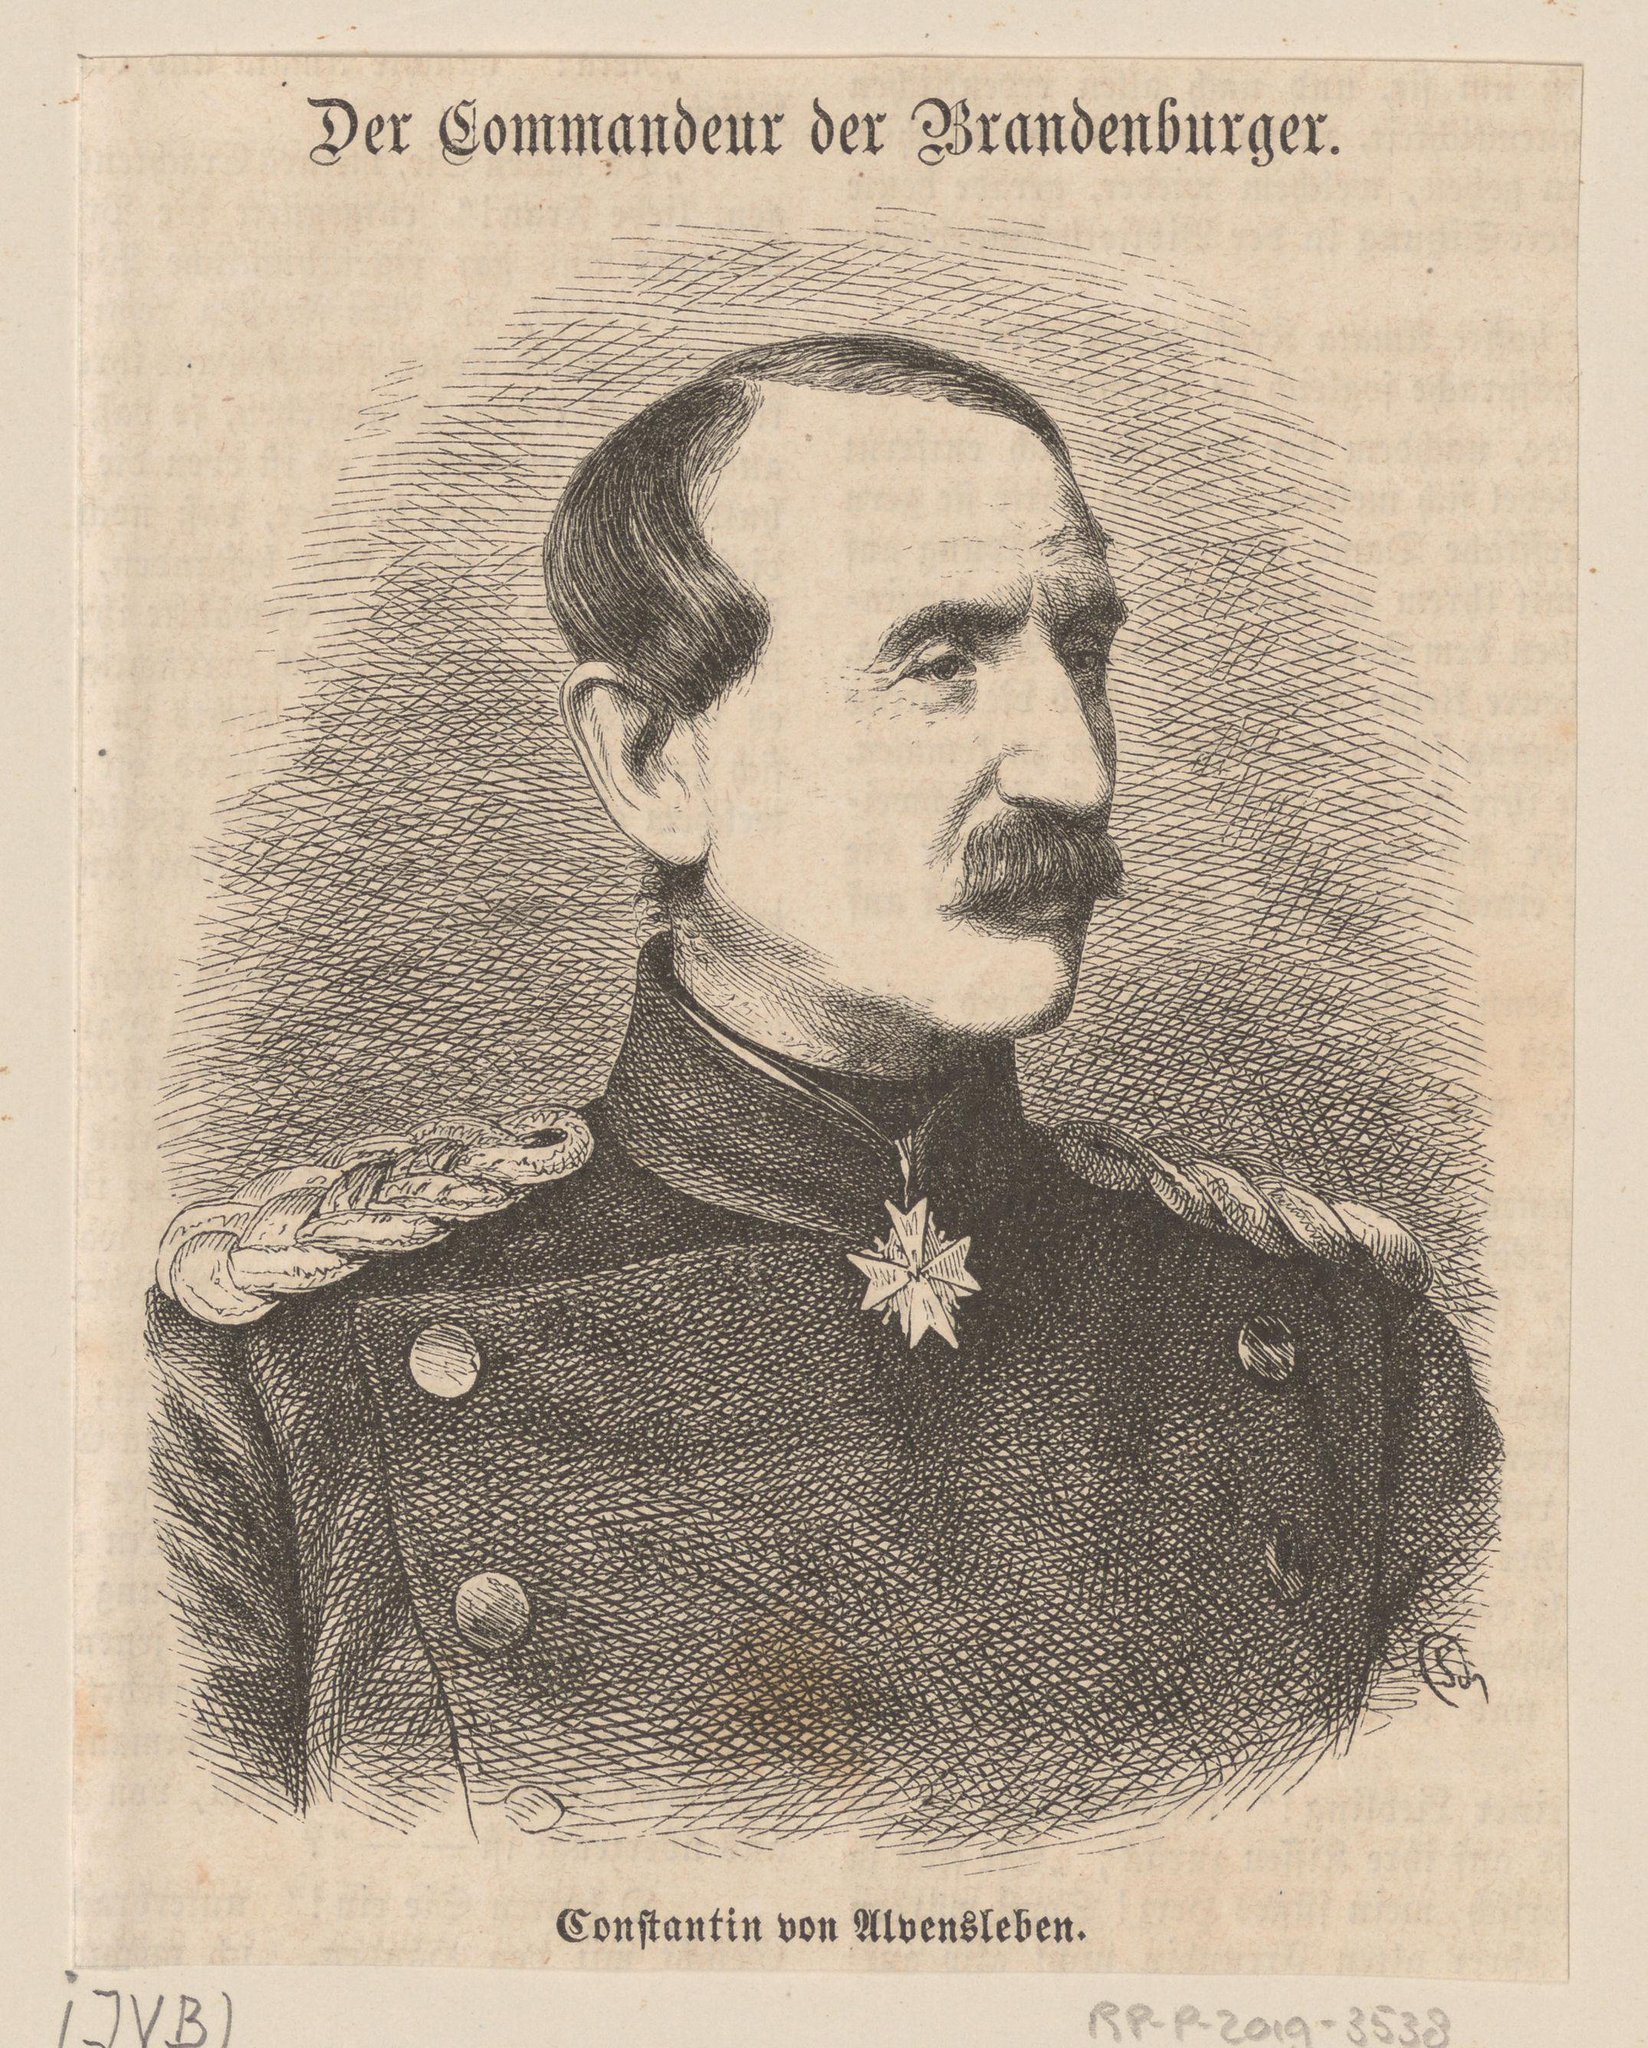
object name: book illustration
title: Portret van Constantin von Alvensleben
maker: Anonymous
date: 1870-1899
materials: paper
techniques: letterpress printing, engraving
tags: berlin, historical persons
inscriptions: collector's mark: ‘JVB’